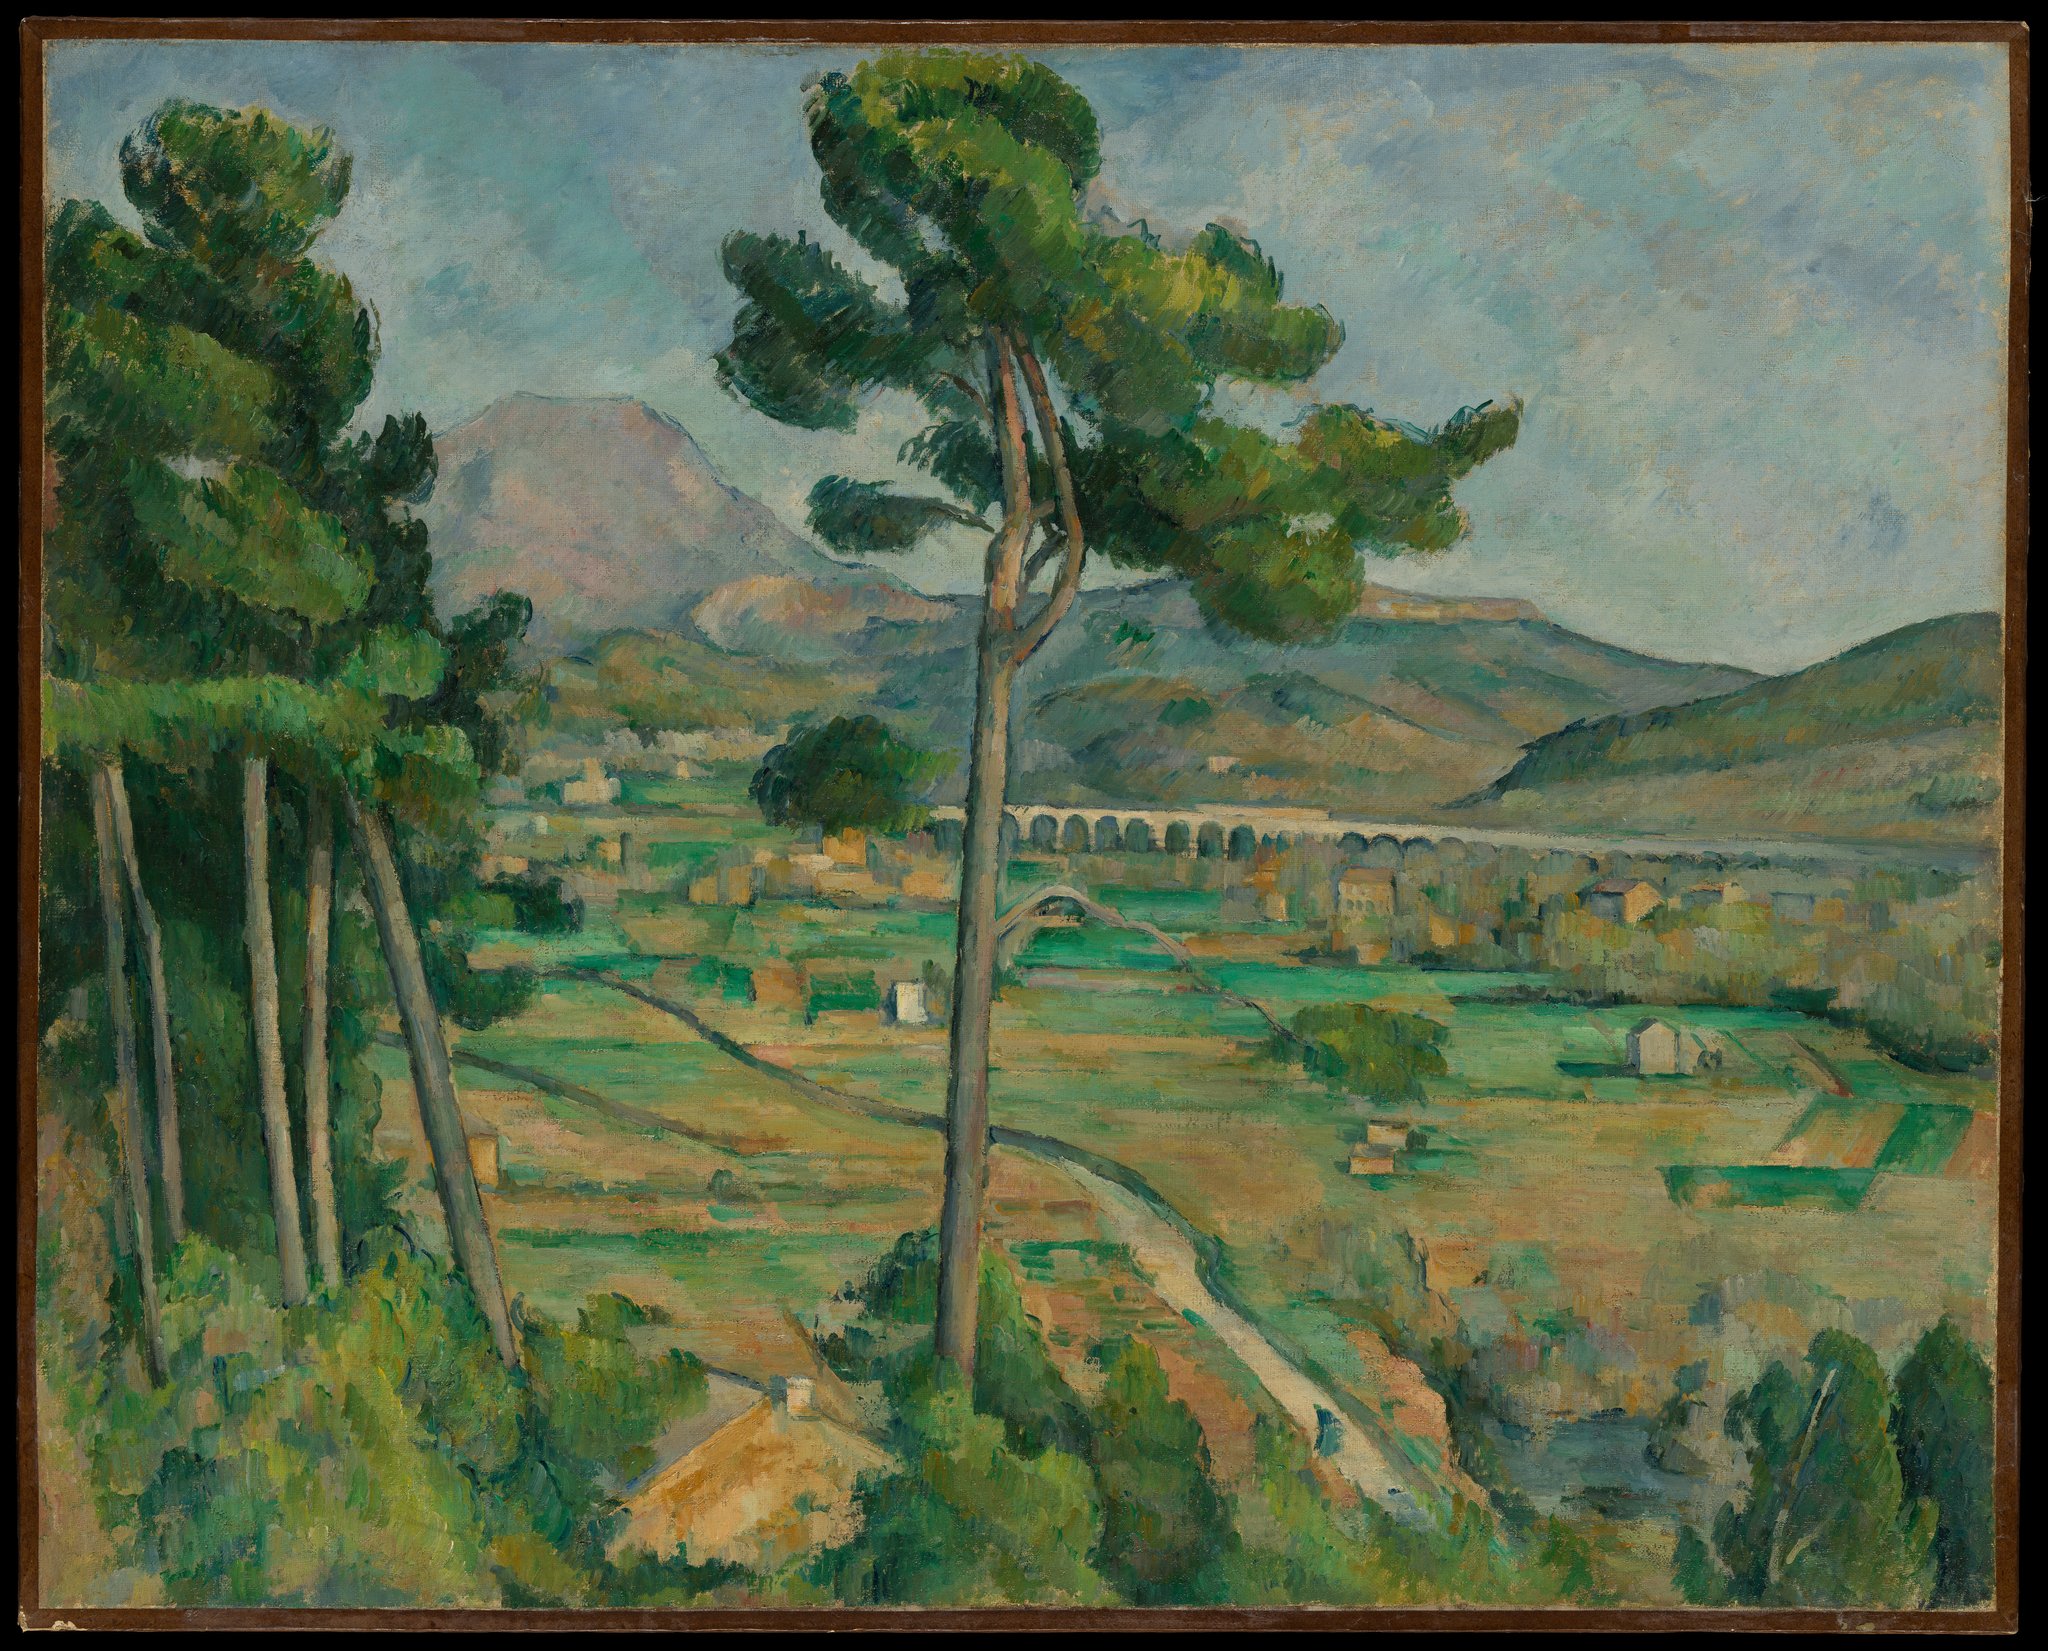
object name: painting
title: Mont Sainte-Victoire and the Viaduct of the Arc River Valley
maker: paul cézanne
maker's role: artist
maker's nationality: french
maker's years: 1839-1906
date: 1882-1885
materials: canvas, oil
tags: bridges,mountains,landscapes